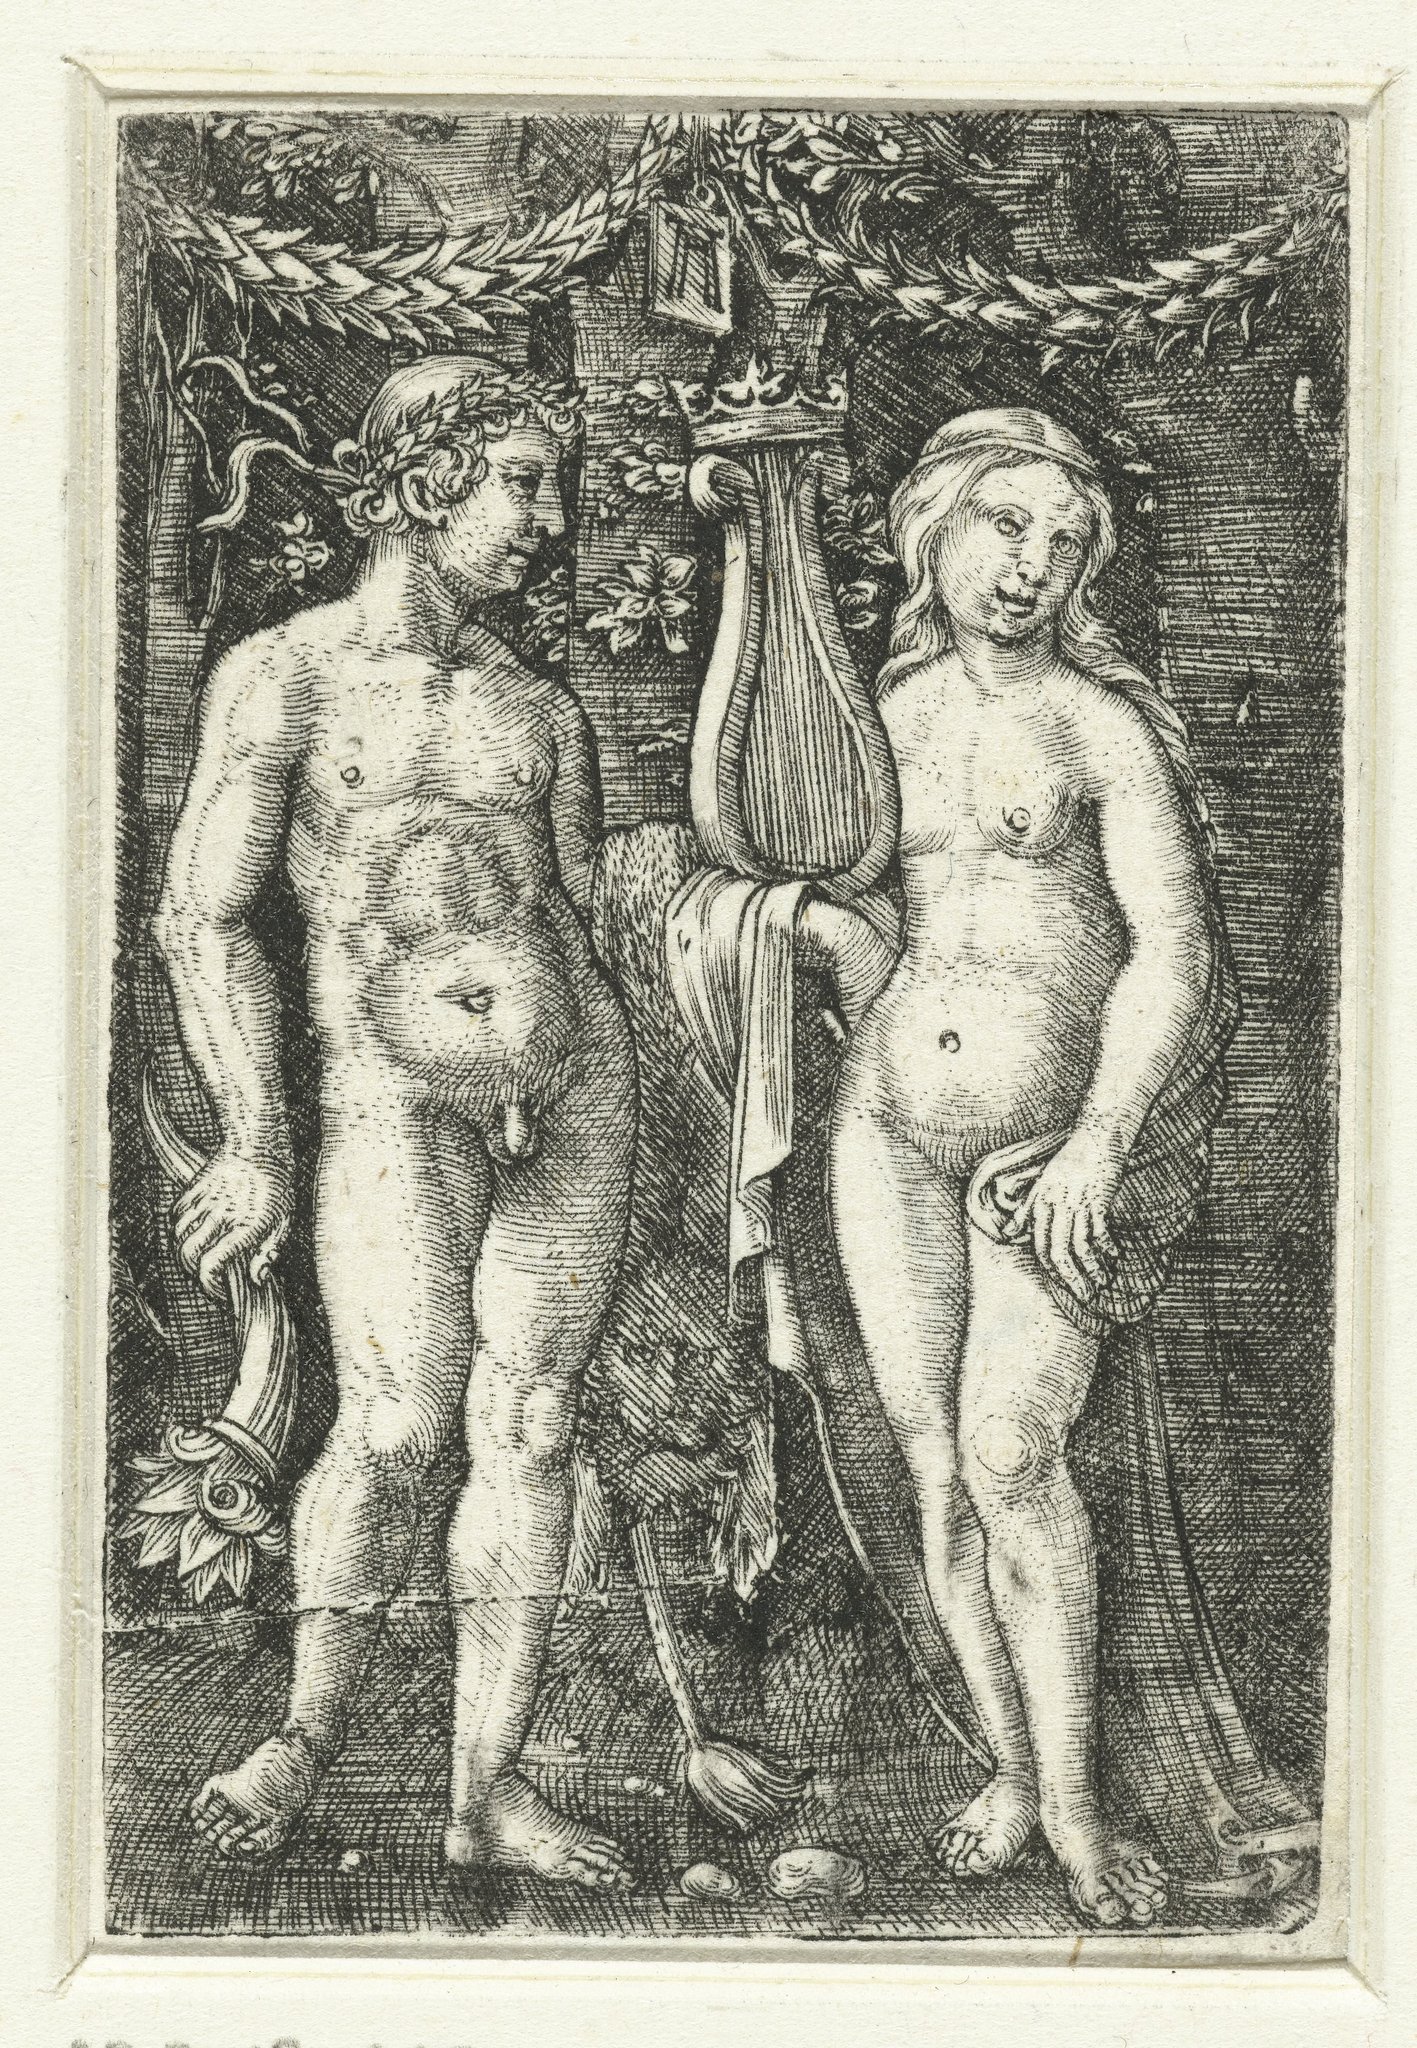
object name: print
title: Hercules en een muze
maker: albrecht altdorfer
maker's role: draughtsman, print maker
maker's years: 1480-1538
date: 1506-1538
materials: paper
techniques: engraving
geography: italy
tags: (story of) hercules (heracles), (story of the) muses; 'muse' (ripa)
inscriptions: number: ‘51’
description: Hercules staand naakt, naast een muze, met een lauwerkrans om zijn hoofd. Het leeuwenvel over zijn arm, in zijn andere hand een hoorn. De muze met een lier op haar arm.